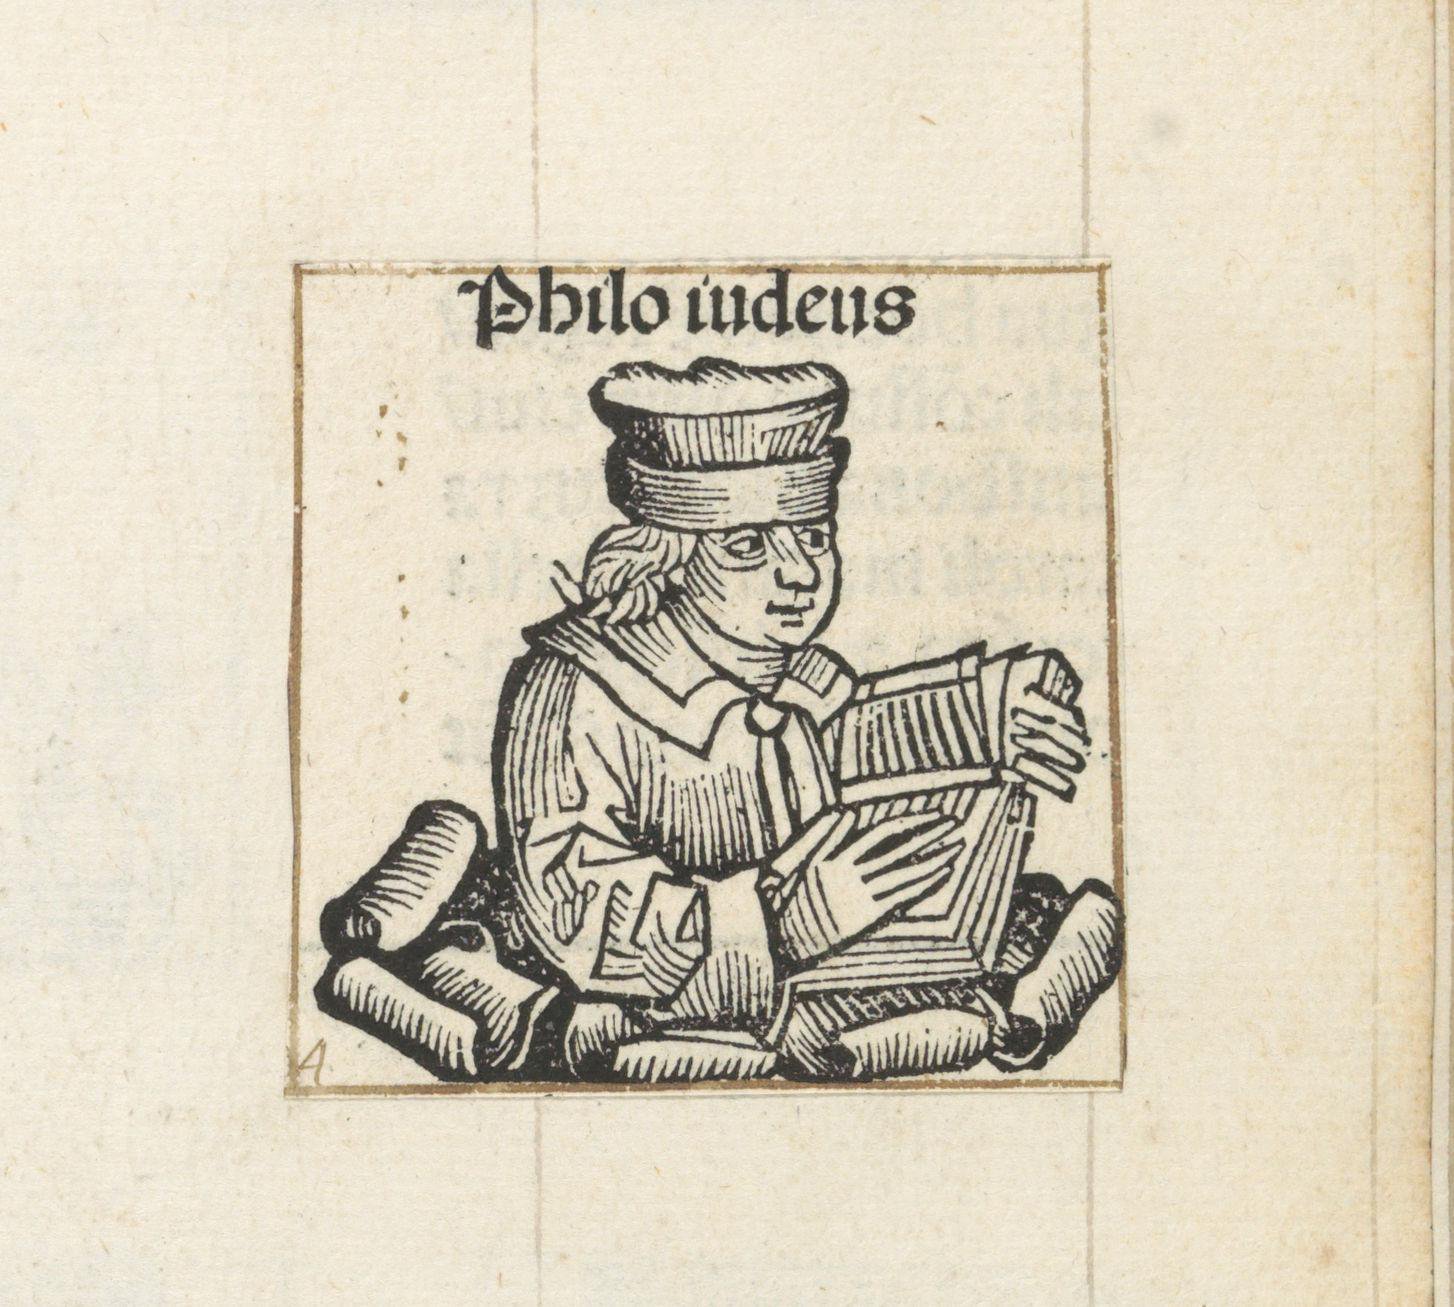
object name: album leaf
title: Liber Chronicarum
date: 1493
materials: paper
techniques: letterpress printing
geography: nuremberg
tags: scholar, philosopher, male persons from classical history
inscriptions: inscription: ‘4’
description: De houtsnede wordt herhaaldelijk gebruikt als boekillustratie in de Liber Chronicarum (of Neurenbergkroniek) van Hartmann Schedel, verschenen in het Latijn en Duits in 1493. Zie de Latijnse uitgave, folio 97r.